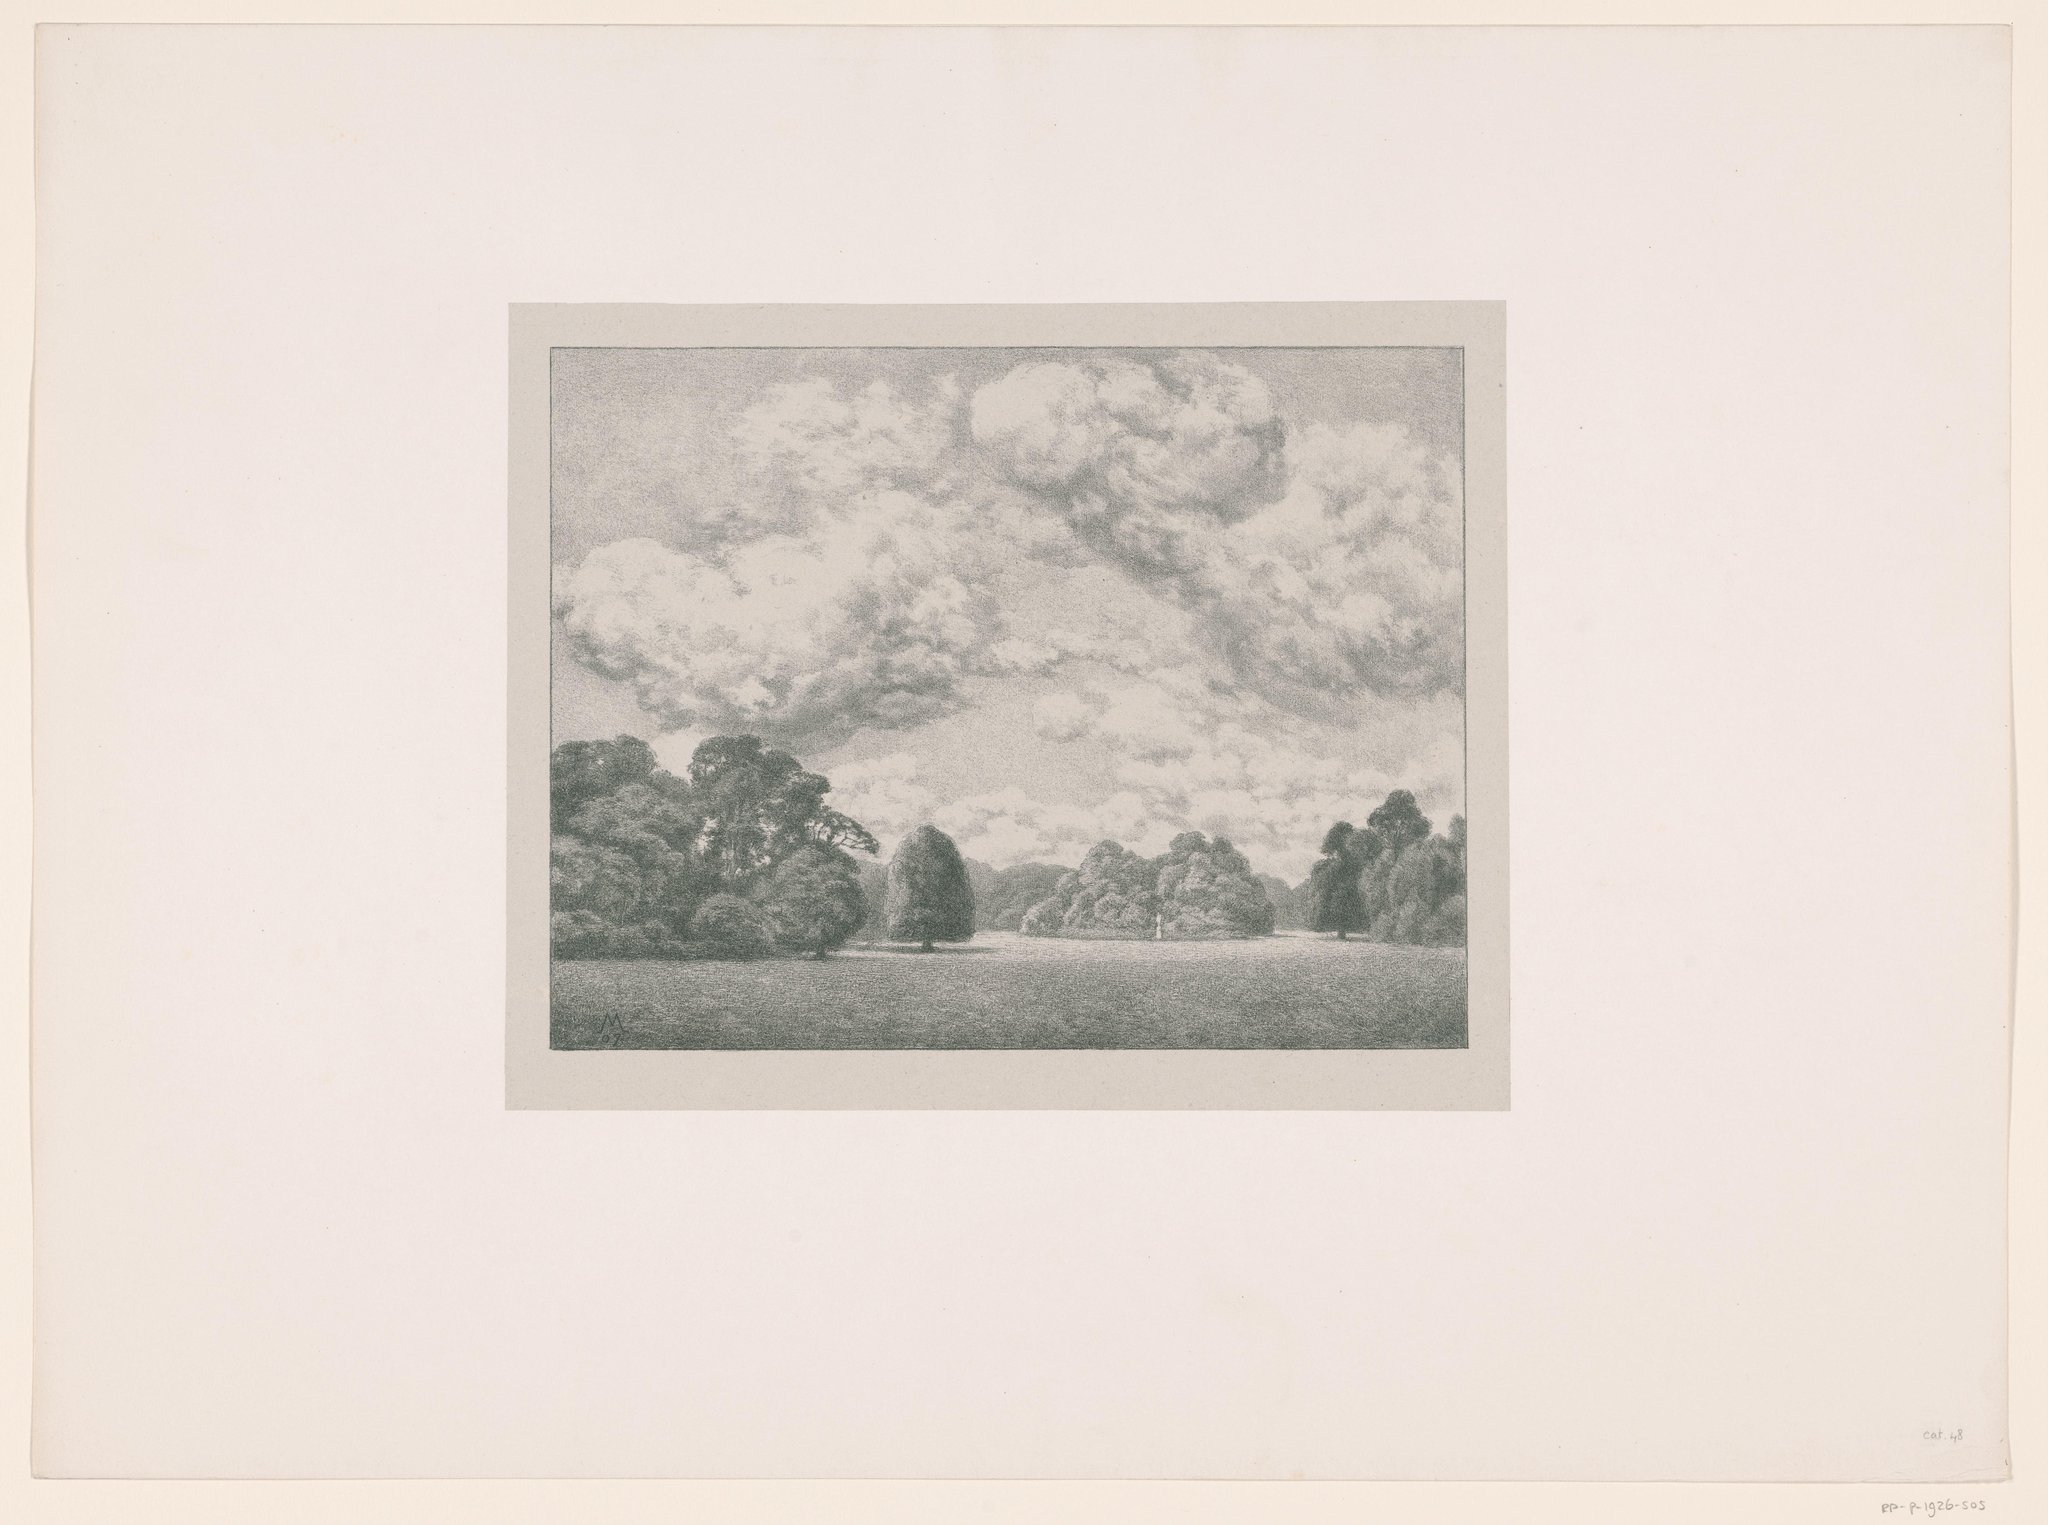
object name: print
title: Het Koninklijk park het Loo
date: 1907-1909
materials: paper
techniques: lithograph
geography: amsterdam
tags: english or landscape garden